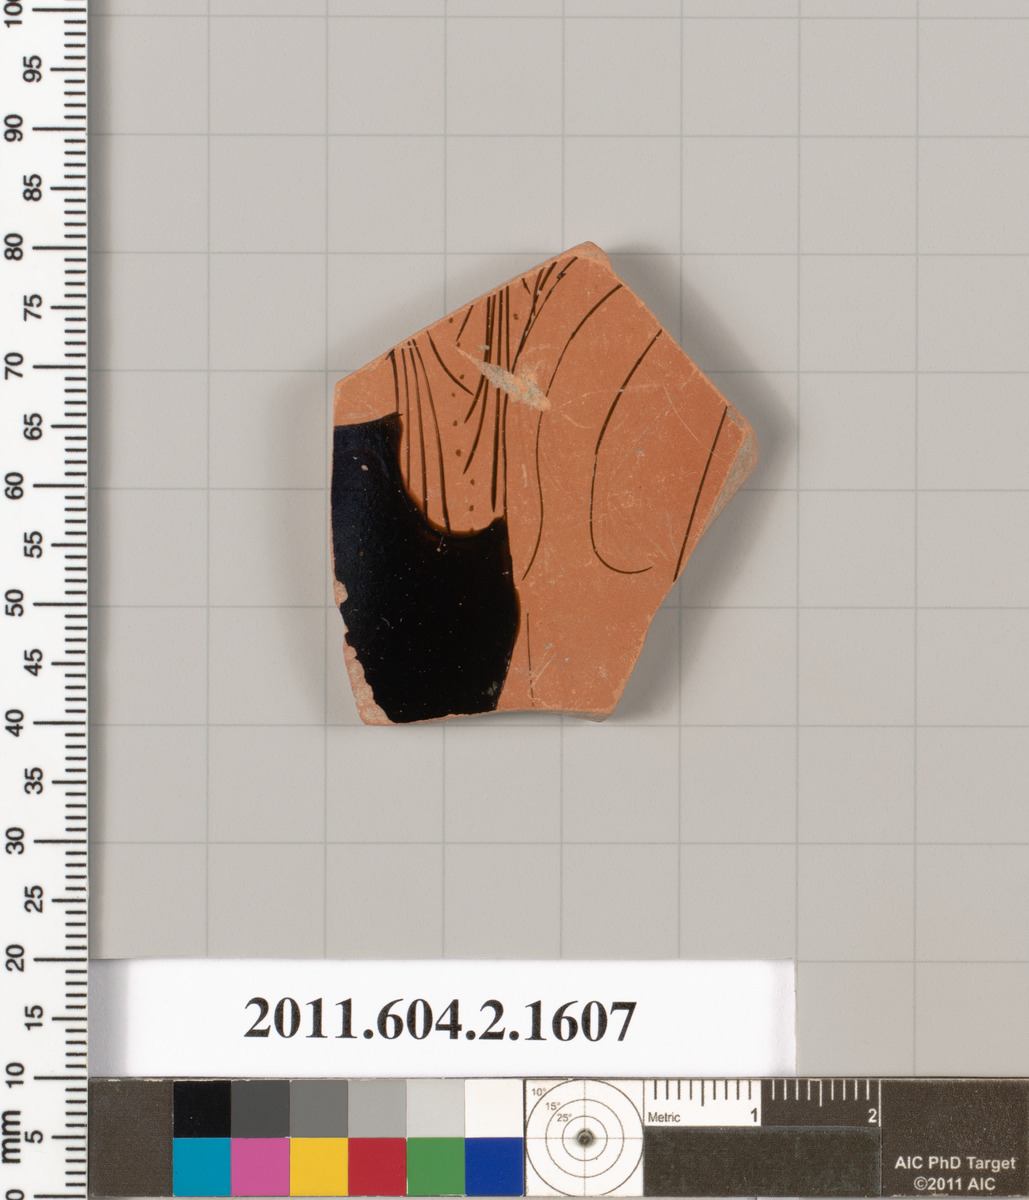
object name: skyphos fragment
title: Terracotta fragment of a skyphos (deep drinking cup)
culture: greek, attic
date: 460-440 BCE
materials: terracotta